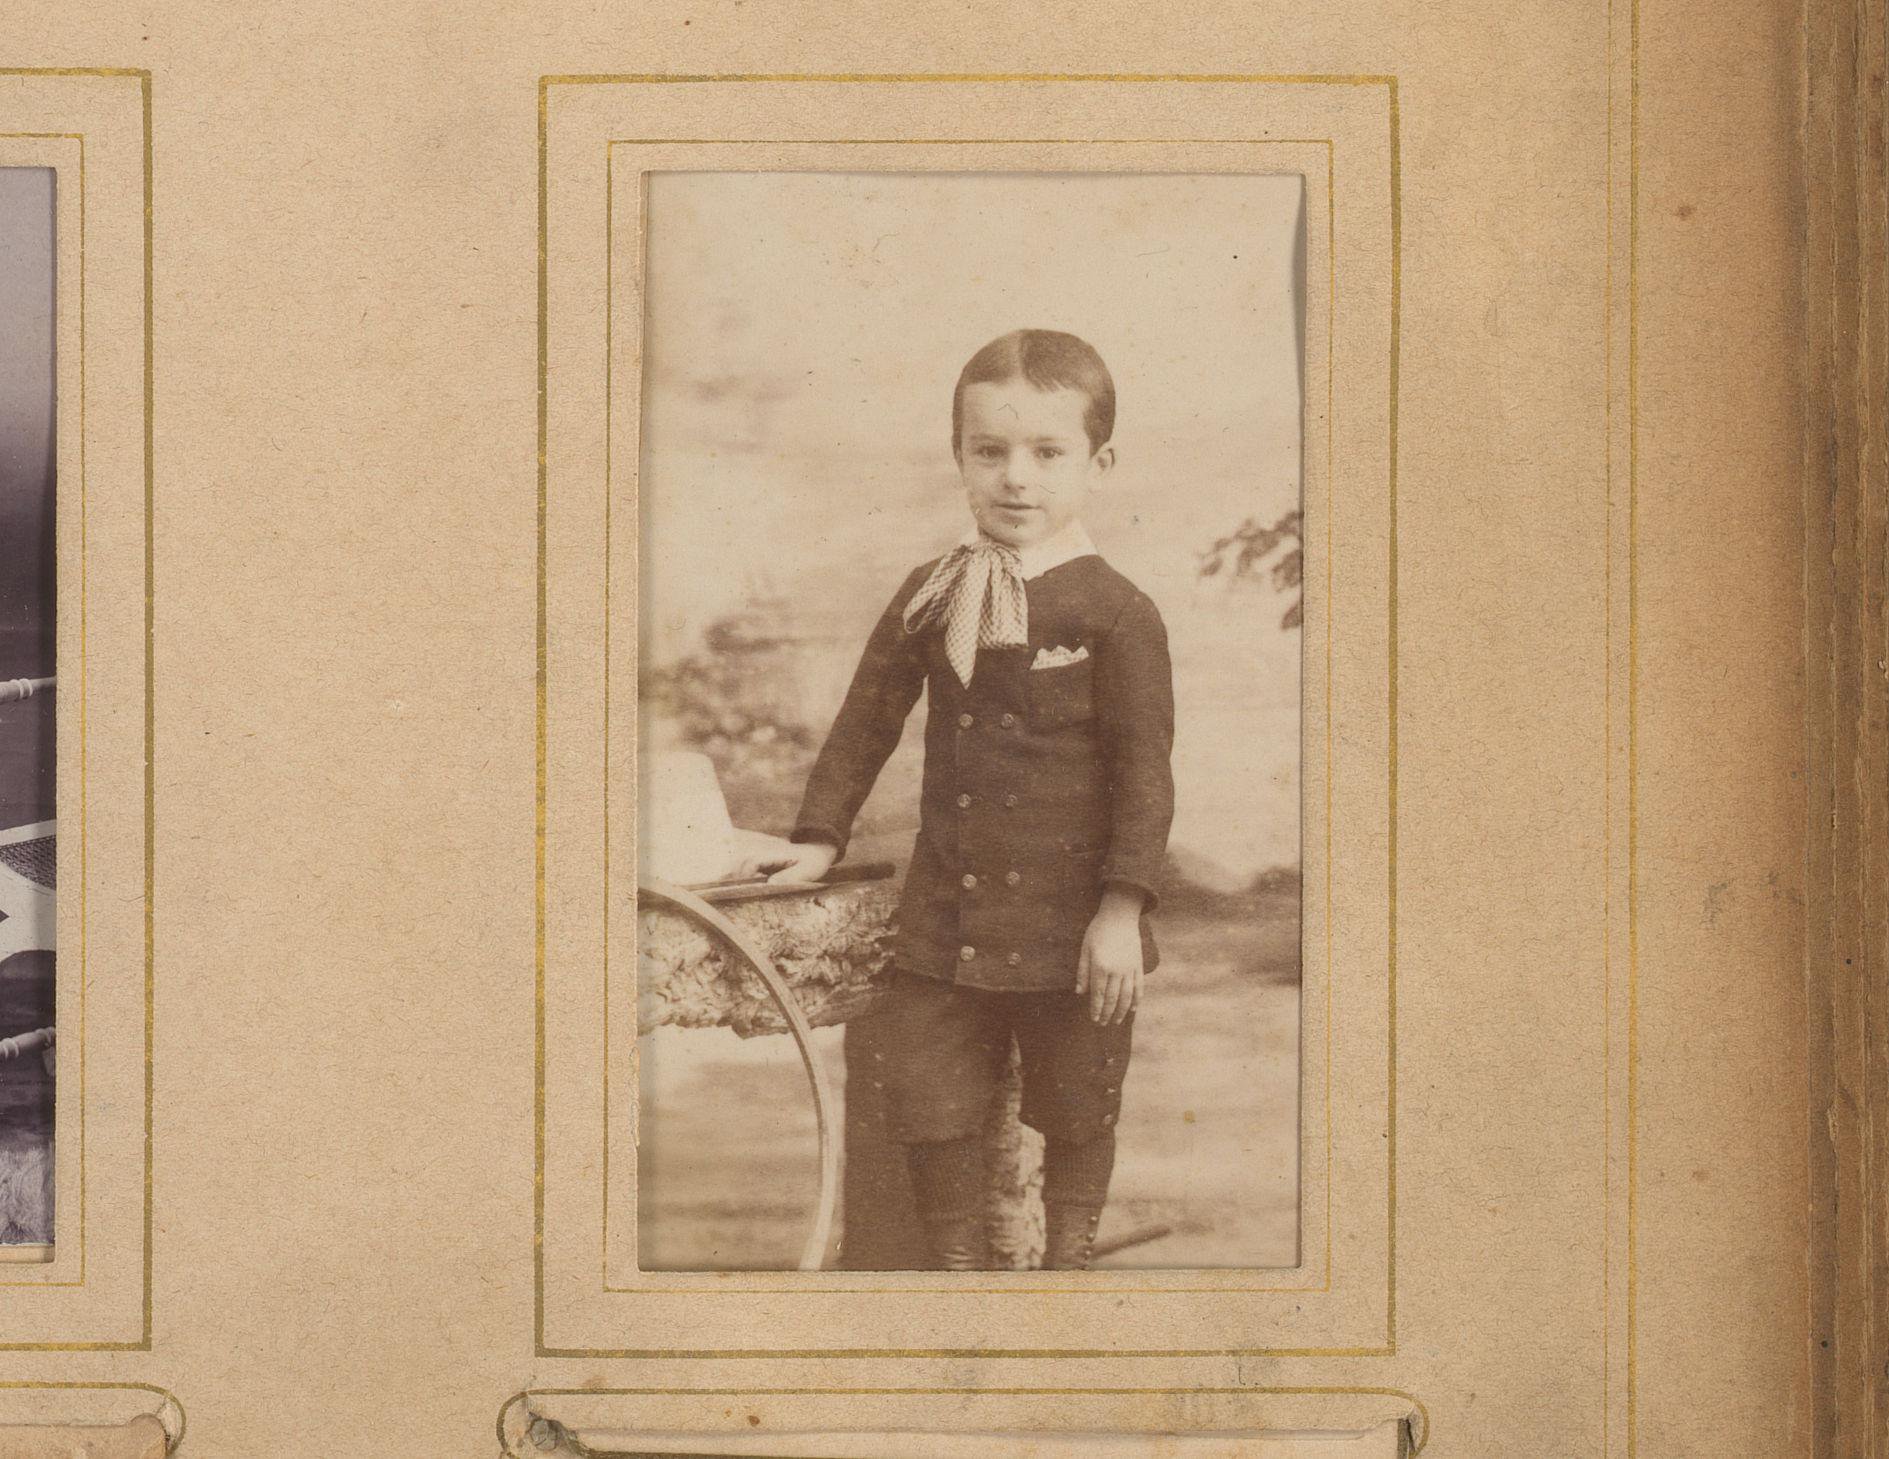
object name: carte de visite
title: Portret van een jongen met een hoepel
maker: a. lavois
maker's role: fotograaf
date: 1895-1915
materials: cardboard, photographic support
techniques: collodion silver print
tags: boy (child between toddler and youth), historical persons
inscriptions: name: ‘ALavois’